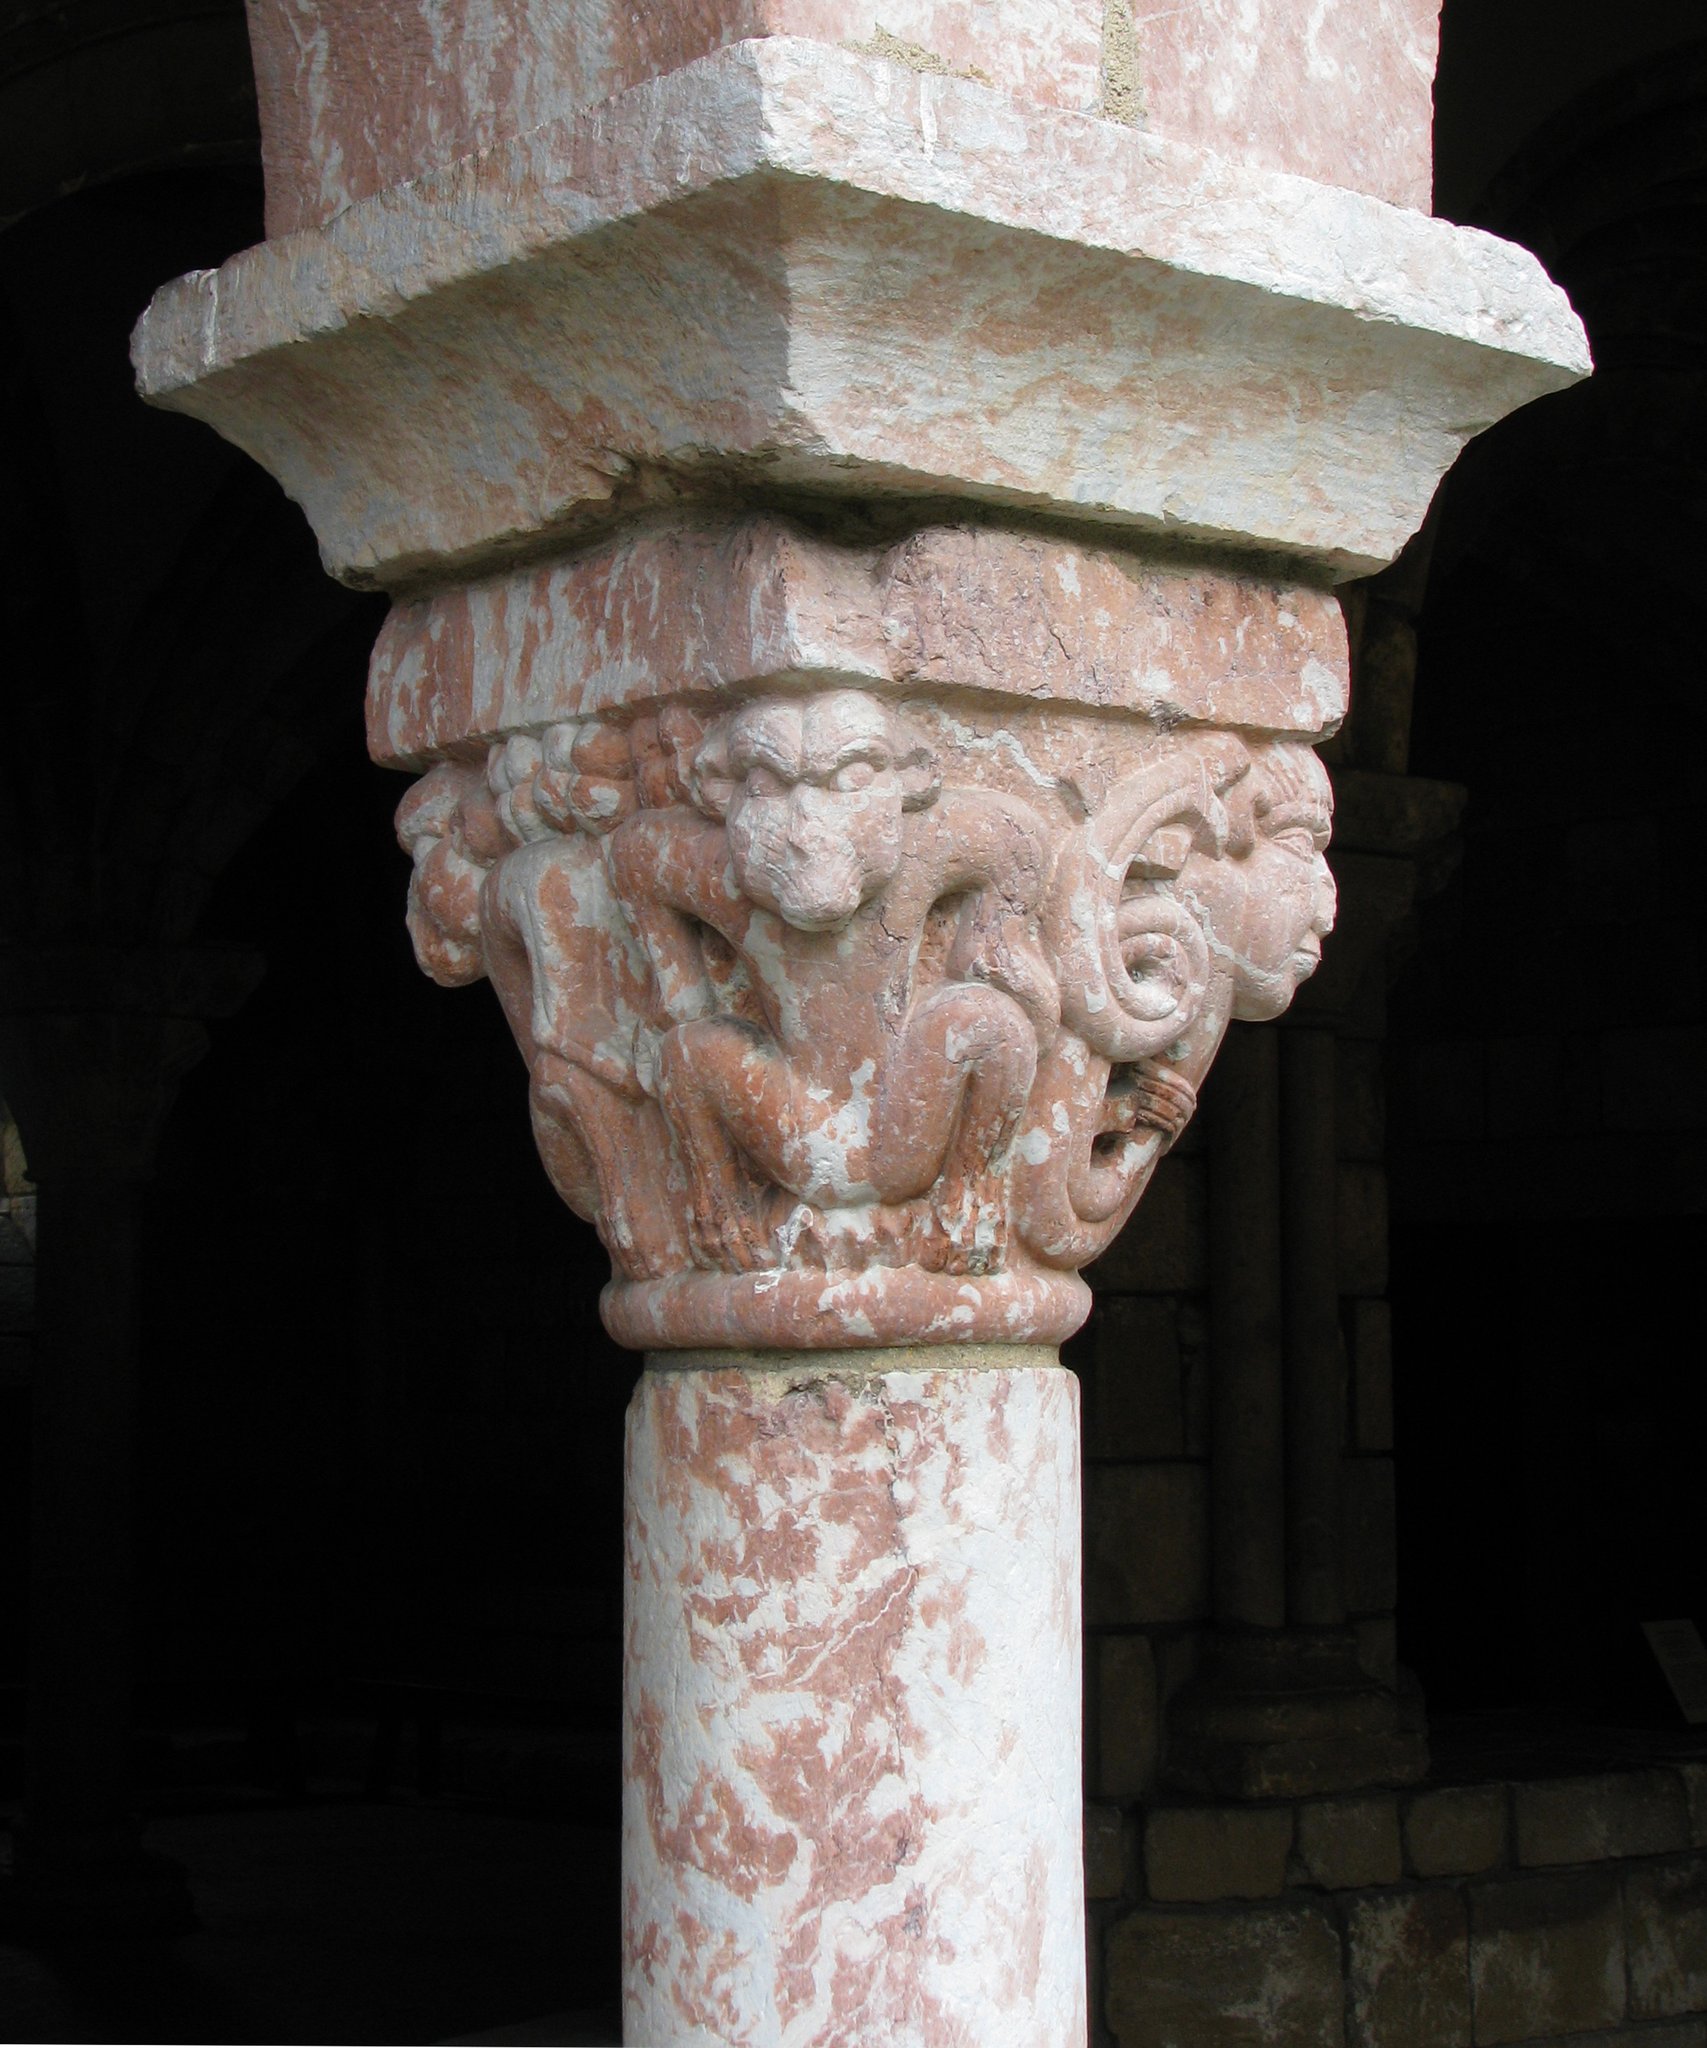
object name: capital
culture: catalan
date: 1130-1140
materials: marble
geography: france